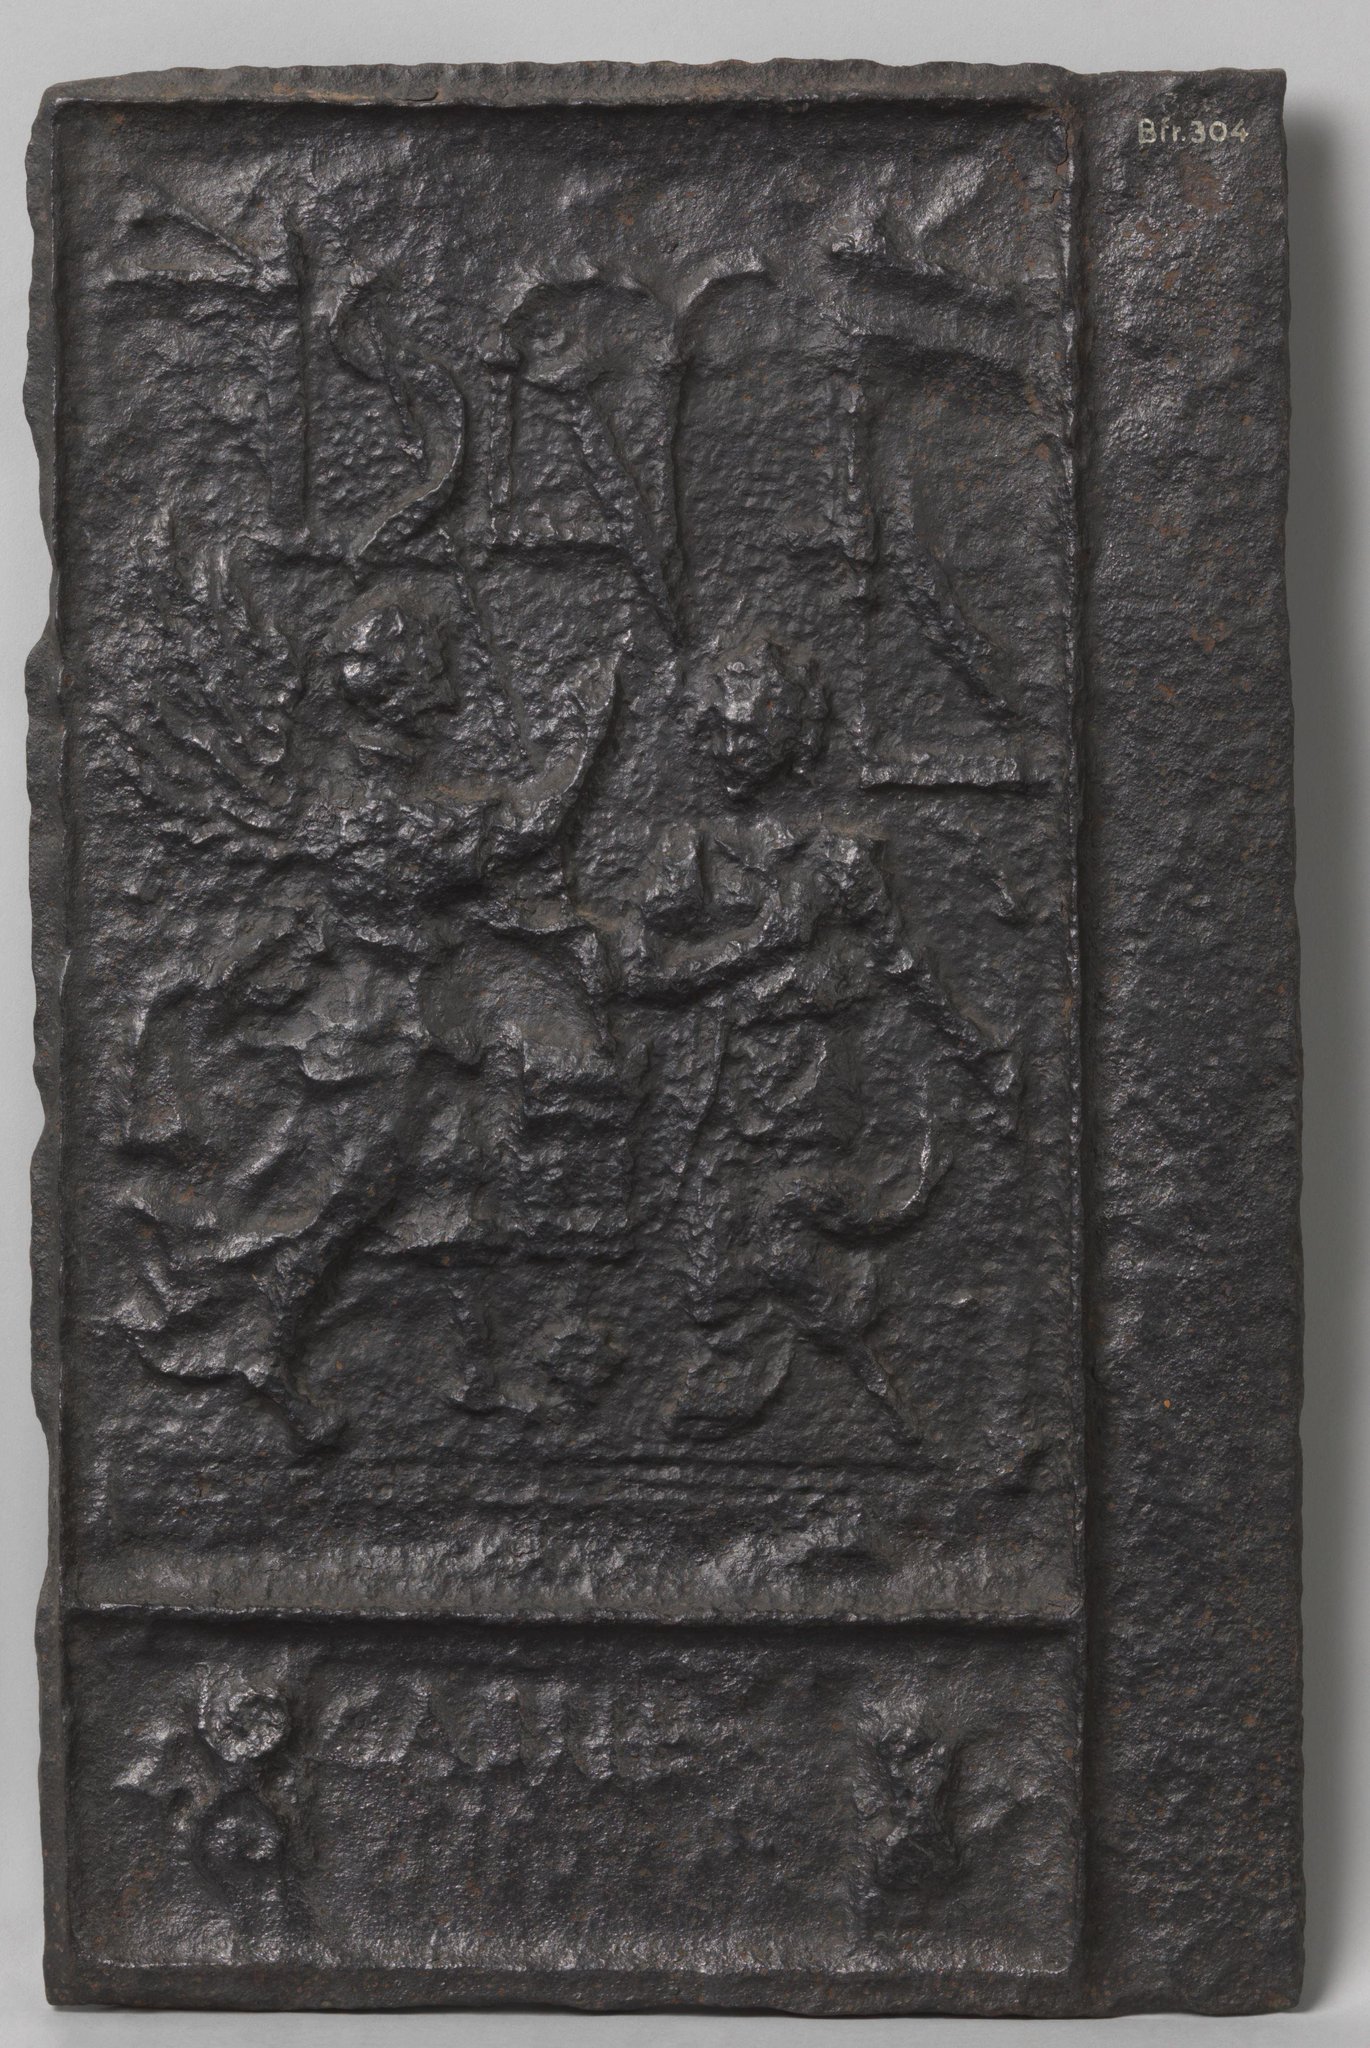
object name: stove plate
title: Kachelplaat met de Annunciatie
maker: Anonymous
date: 1575-1625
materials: iron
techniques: casting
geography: germany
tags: the annunciation: mary, usually reading, is visited by the angel (sometimes a woman overhears the conversation)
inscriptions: inscription: ‘GABRIE[L] / [...]’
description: Kachelplaat van gietijzer, verdeeld in twee zones. In de bovenste zone is een voorstelling van de Annunciatie, waarbij de engel links aan Maria haar zwangerschap verkondigd. Bovenaan het tafereel zijn enkele bogen te zien, onder één daarvan staat een vaas met een lelie. De onderste zone is voorzien van een cartouche met opschrift: GABRIEL.